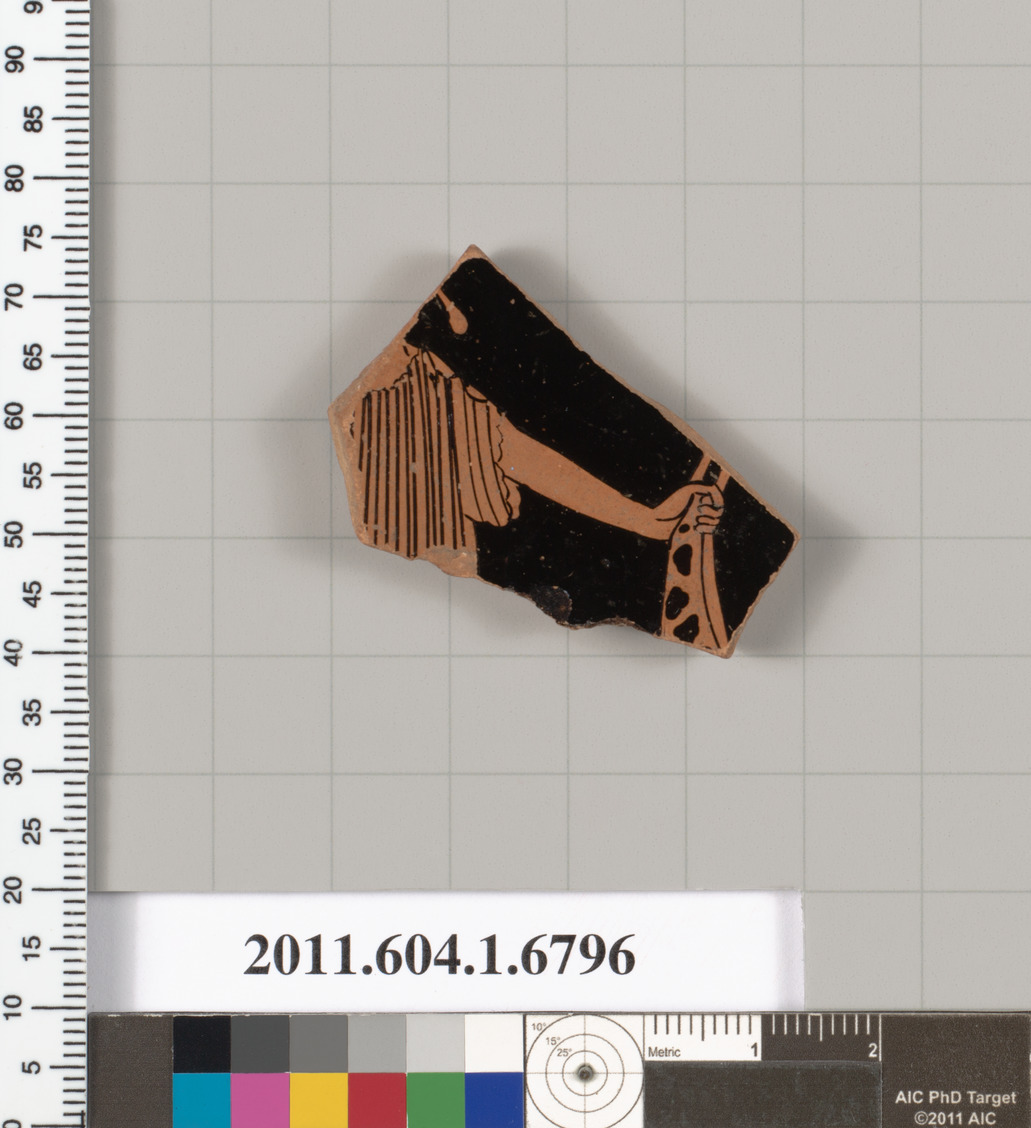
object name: kylix fragment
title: Terracotta fragment of a kylix (drinking cup)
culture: greek, attic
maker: brygos painter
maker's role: artist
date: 490-470 BCE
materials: terracotta